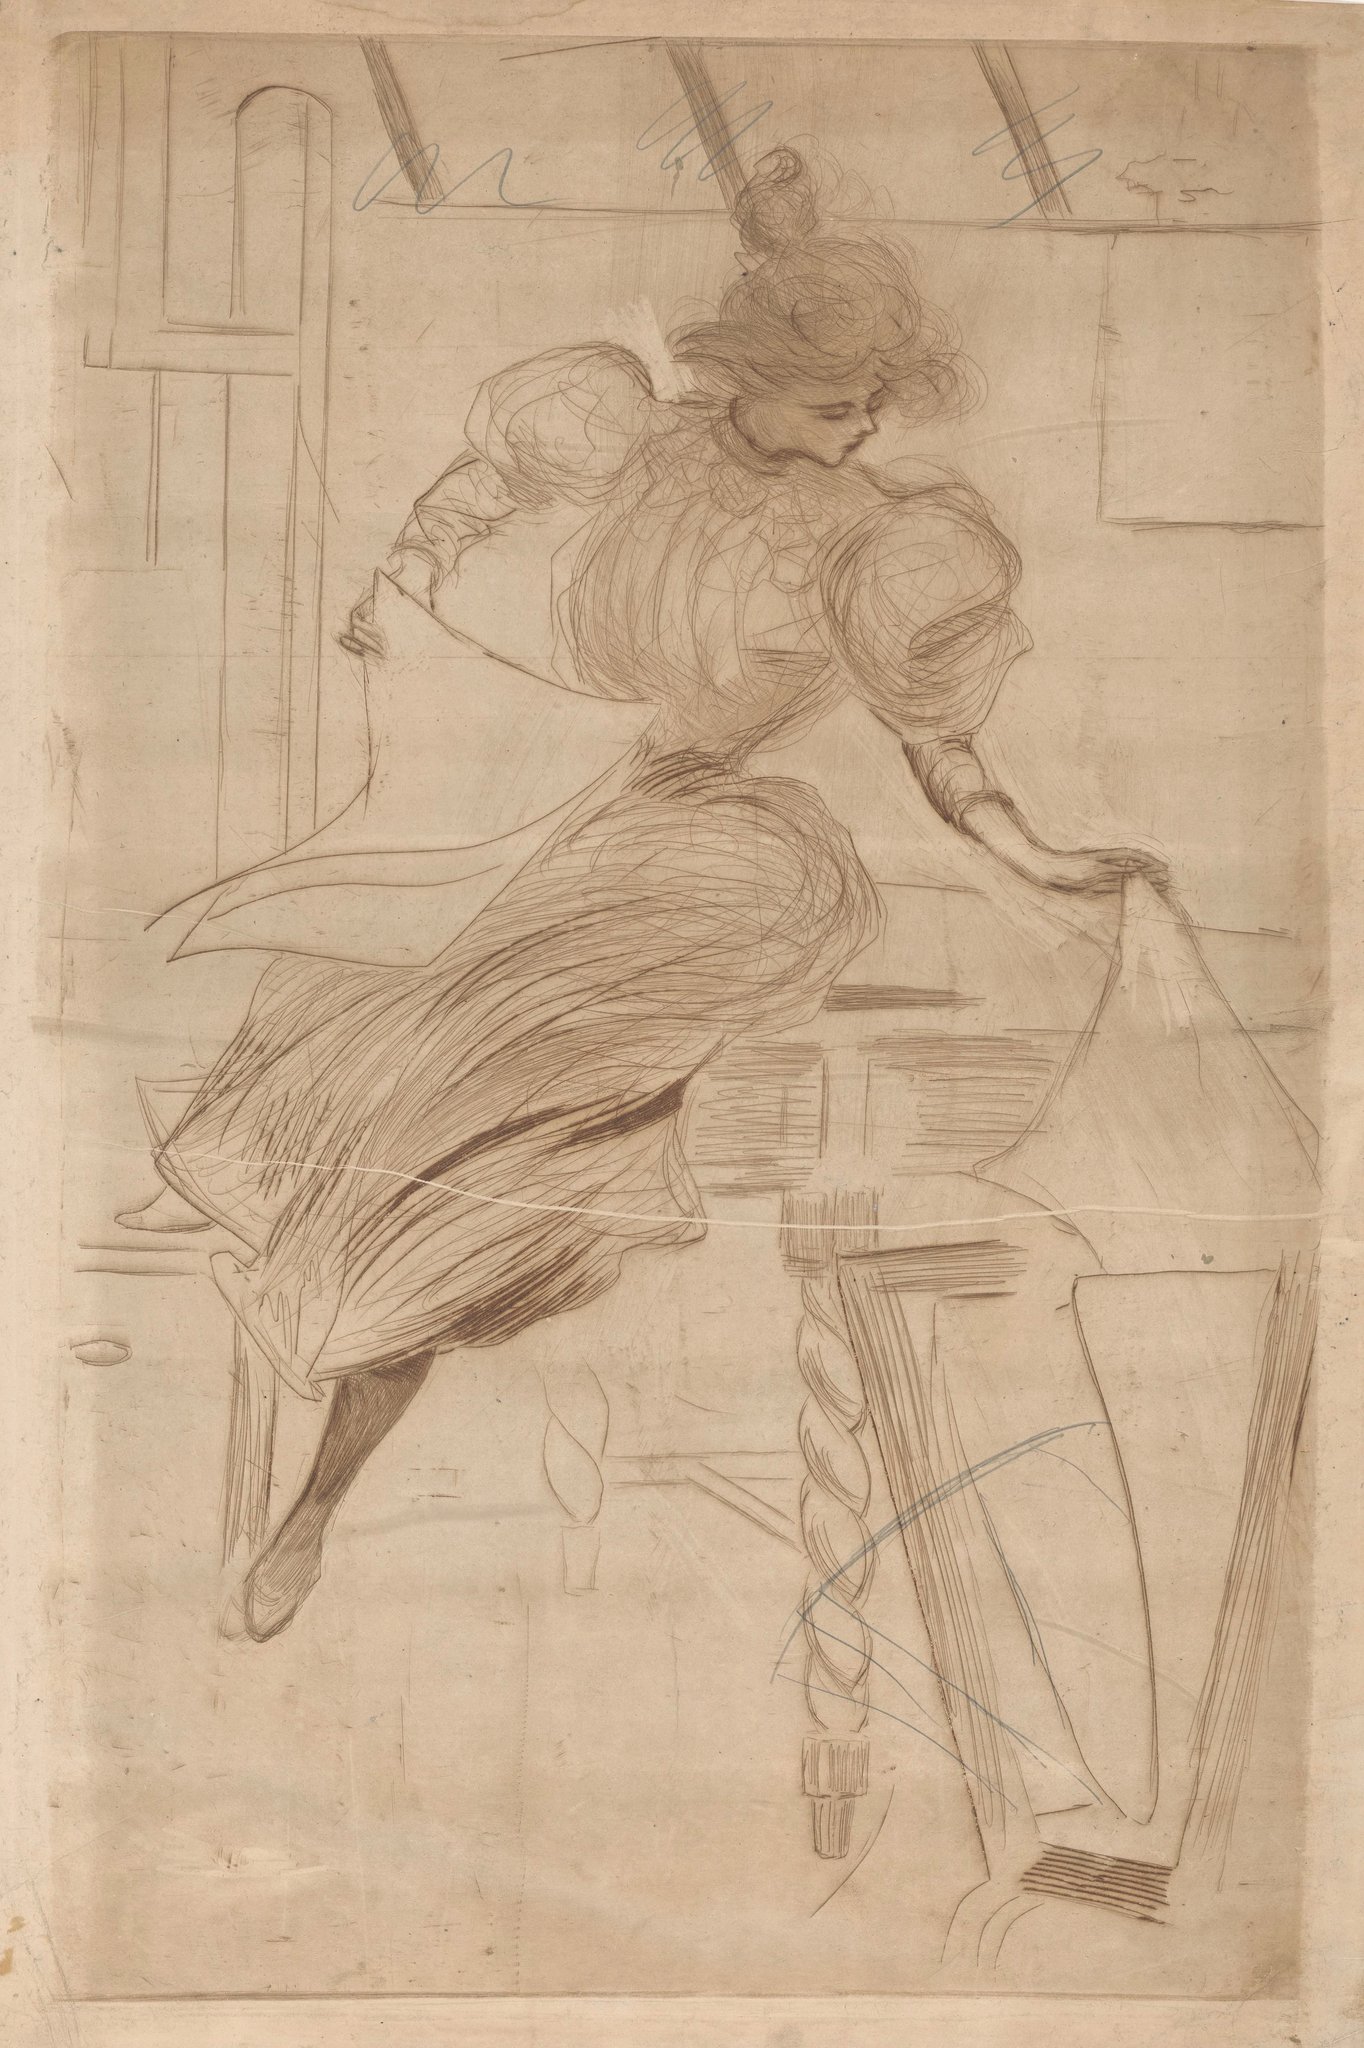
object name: print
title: Vrouw bekijkt prenten in een prentstandaard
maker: henri boutet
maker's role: draughtsman, print maker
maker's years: 1851-1919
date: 1861-1919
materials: paper, pencil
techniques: drypoint, intaglio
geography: france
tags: print, e.g.: engraving, etching, lithograph, art collector (+ graphic arts)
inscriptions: annotation: ‘T. d'essai I’, collector's mark: Lugt 4779, collector's mark: Lugt 2228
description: Op een tafel zit een vrouw met in haar rechterhand een prent. Met haar linkerhand pakt ze een andere prent uit een prentstandaard.